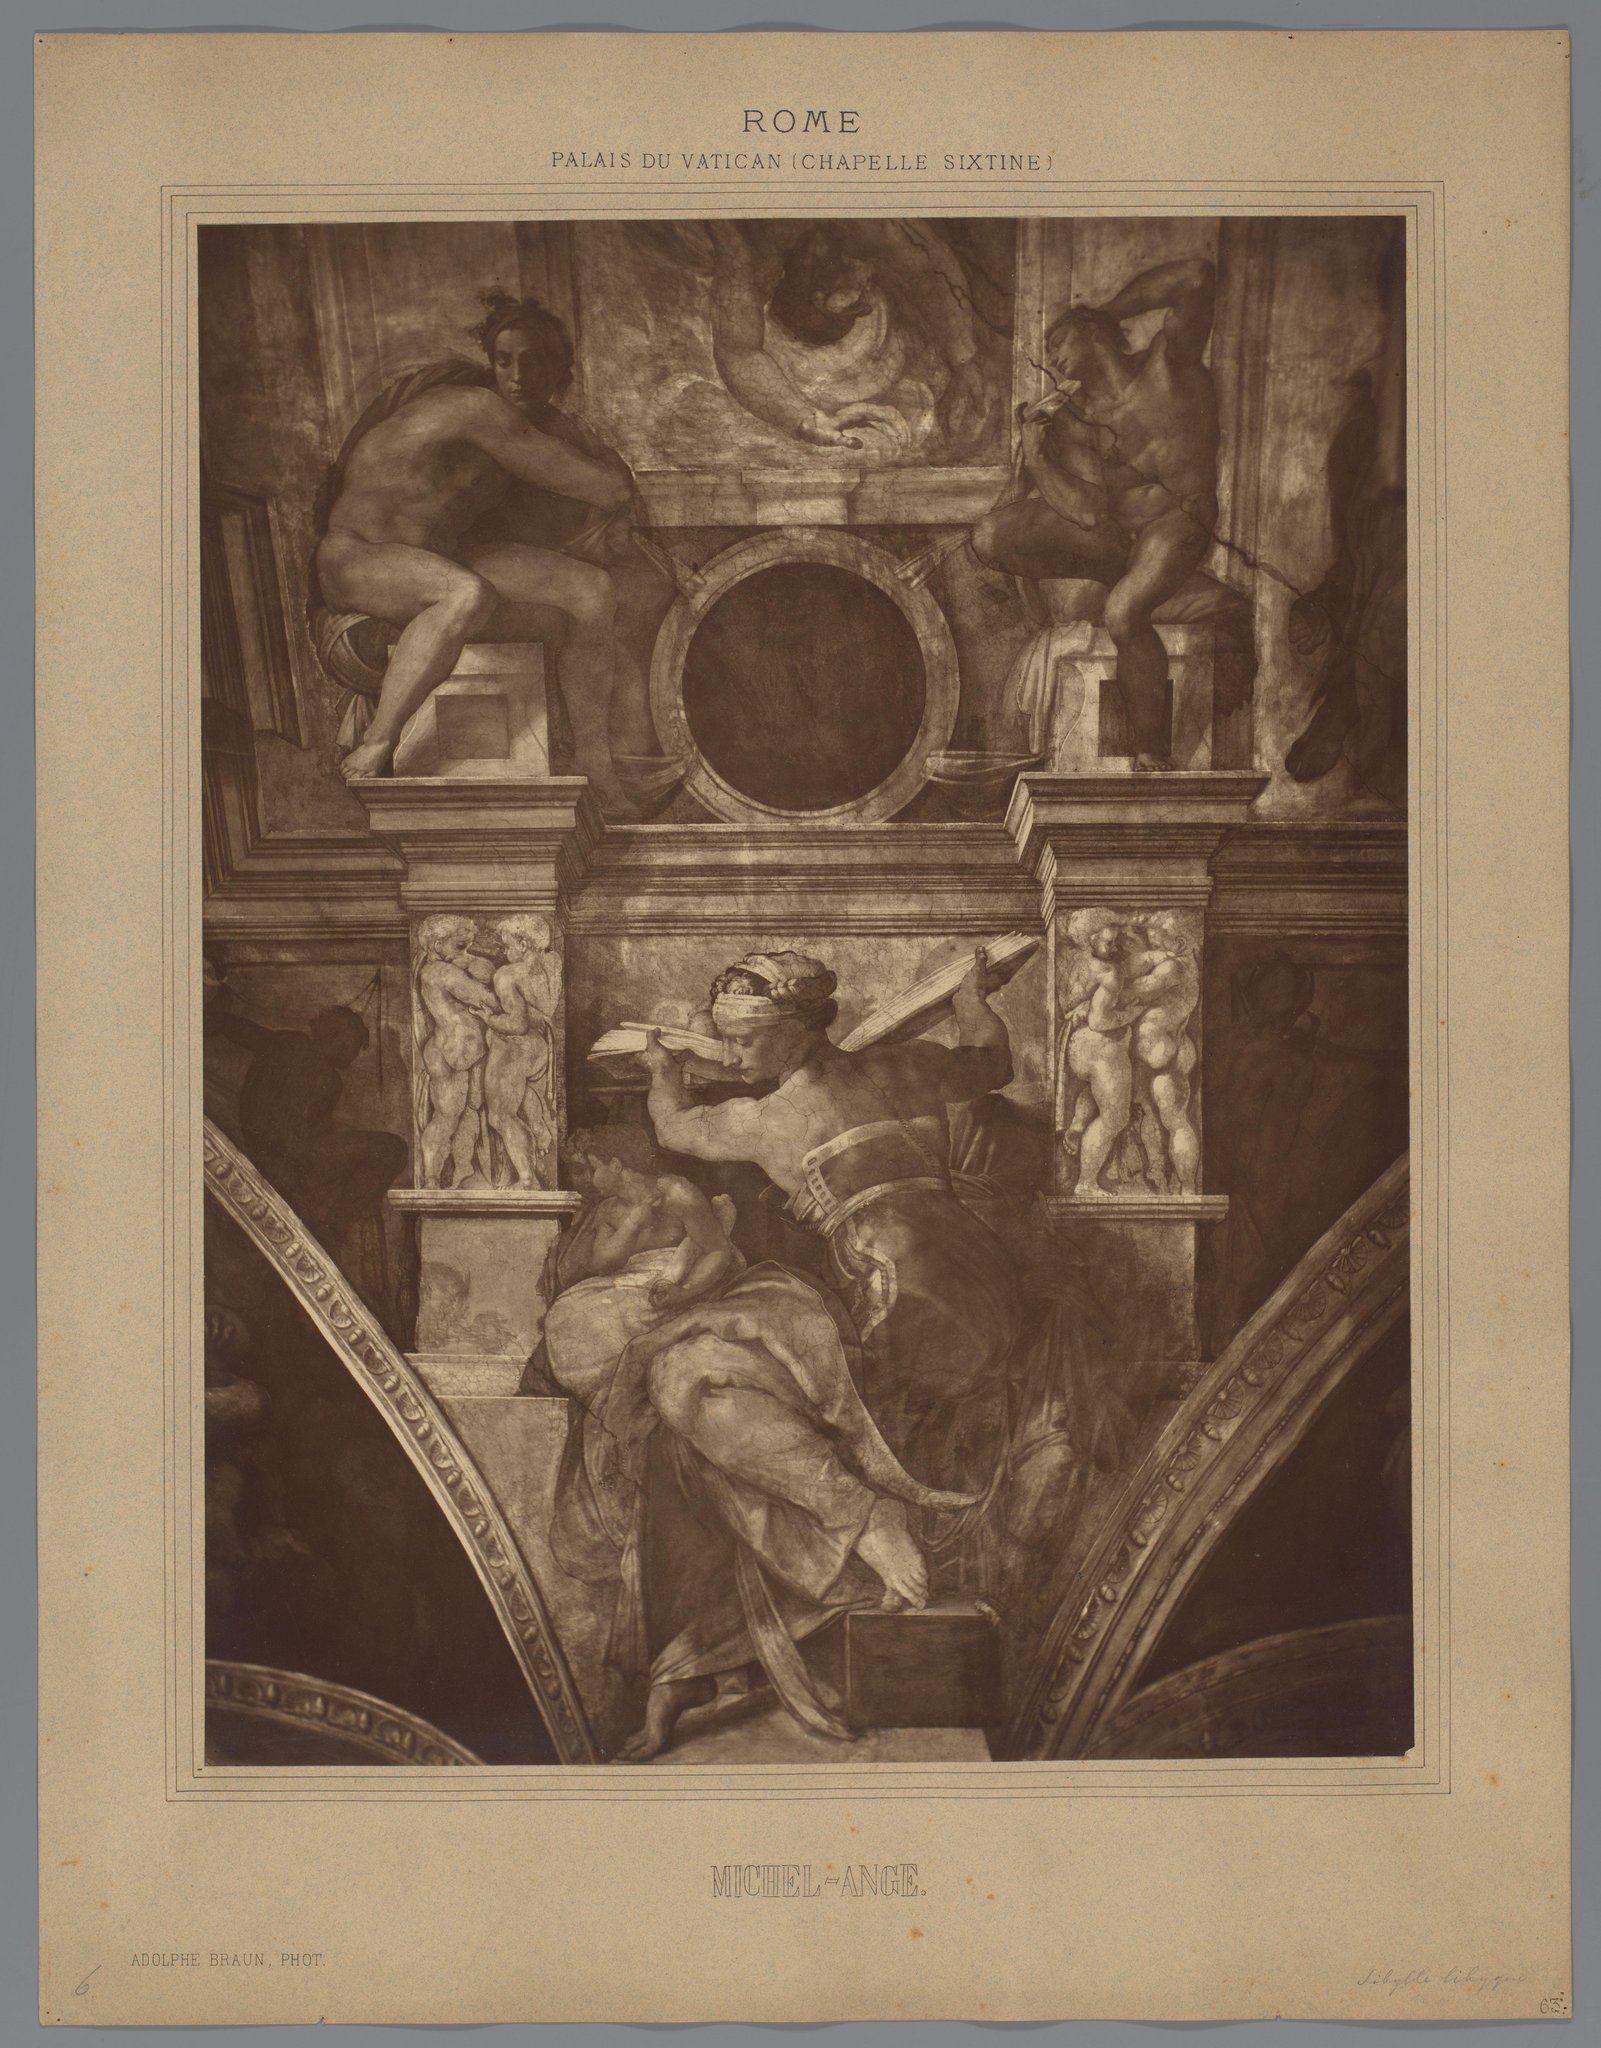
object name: photograph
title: Fotoreproductie van een fresco van Michelangelo in de Sixtijnse Kapel, 'De Libische Sibille'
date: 1880-1900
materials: cardboard, paper, photographic support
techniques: carbon print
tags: sixtijnse kapel (vaticaan)